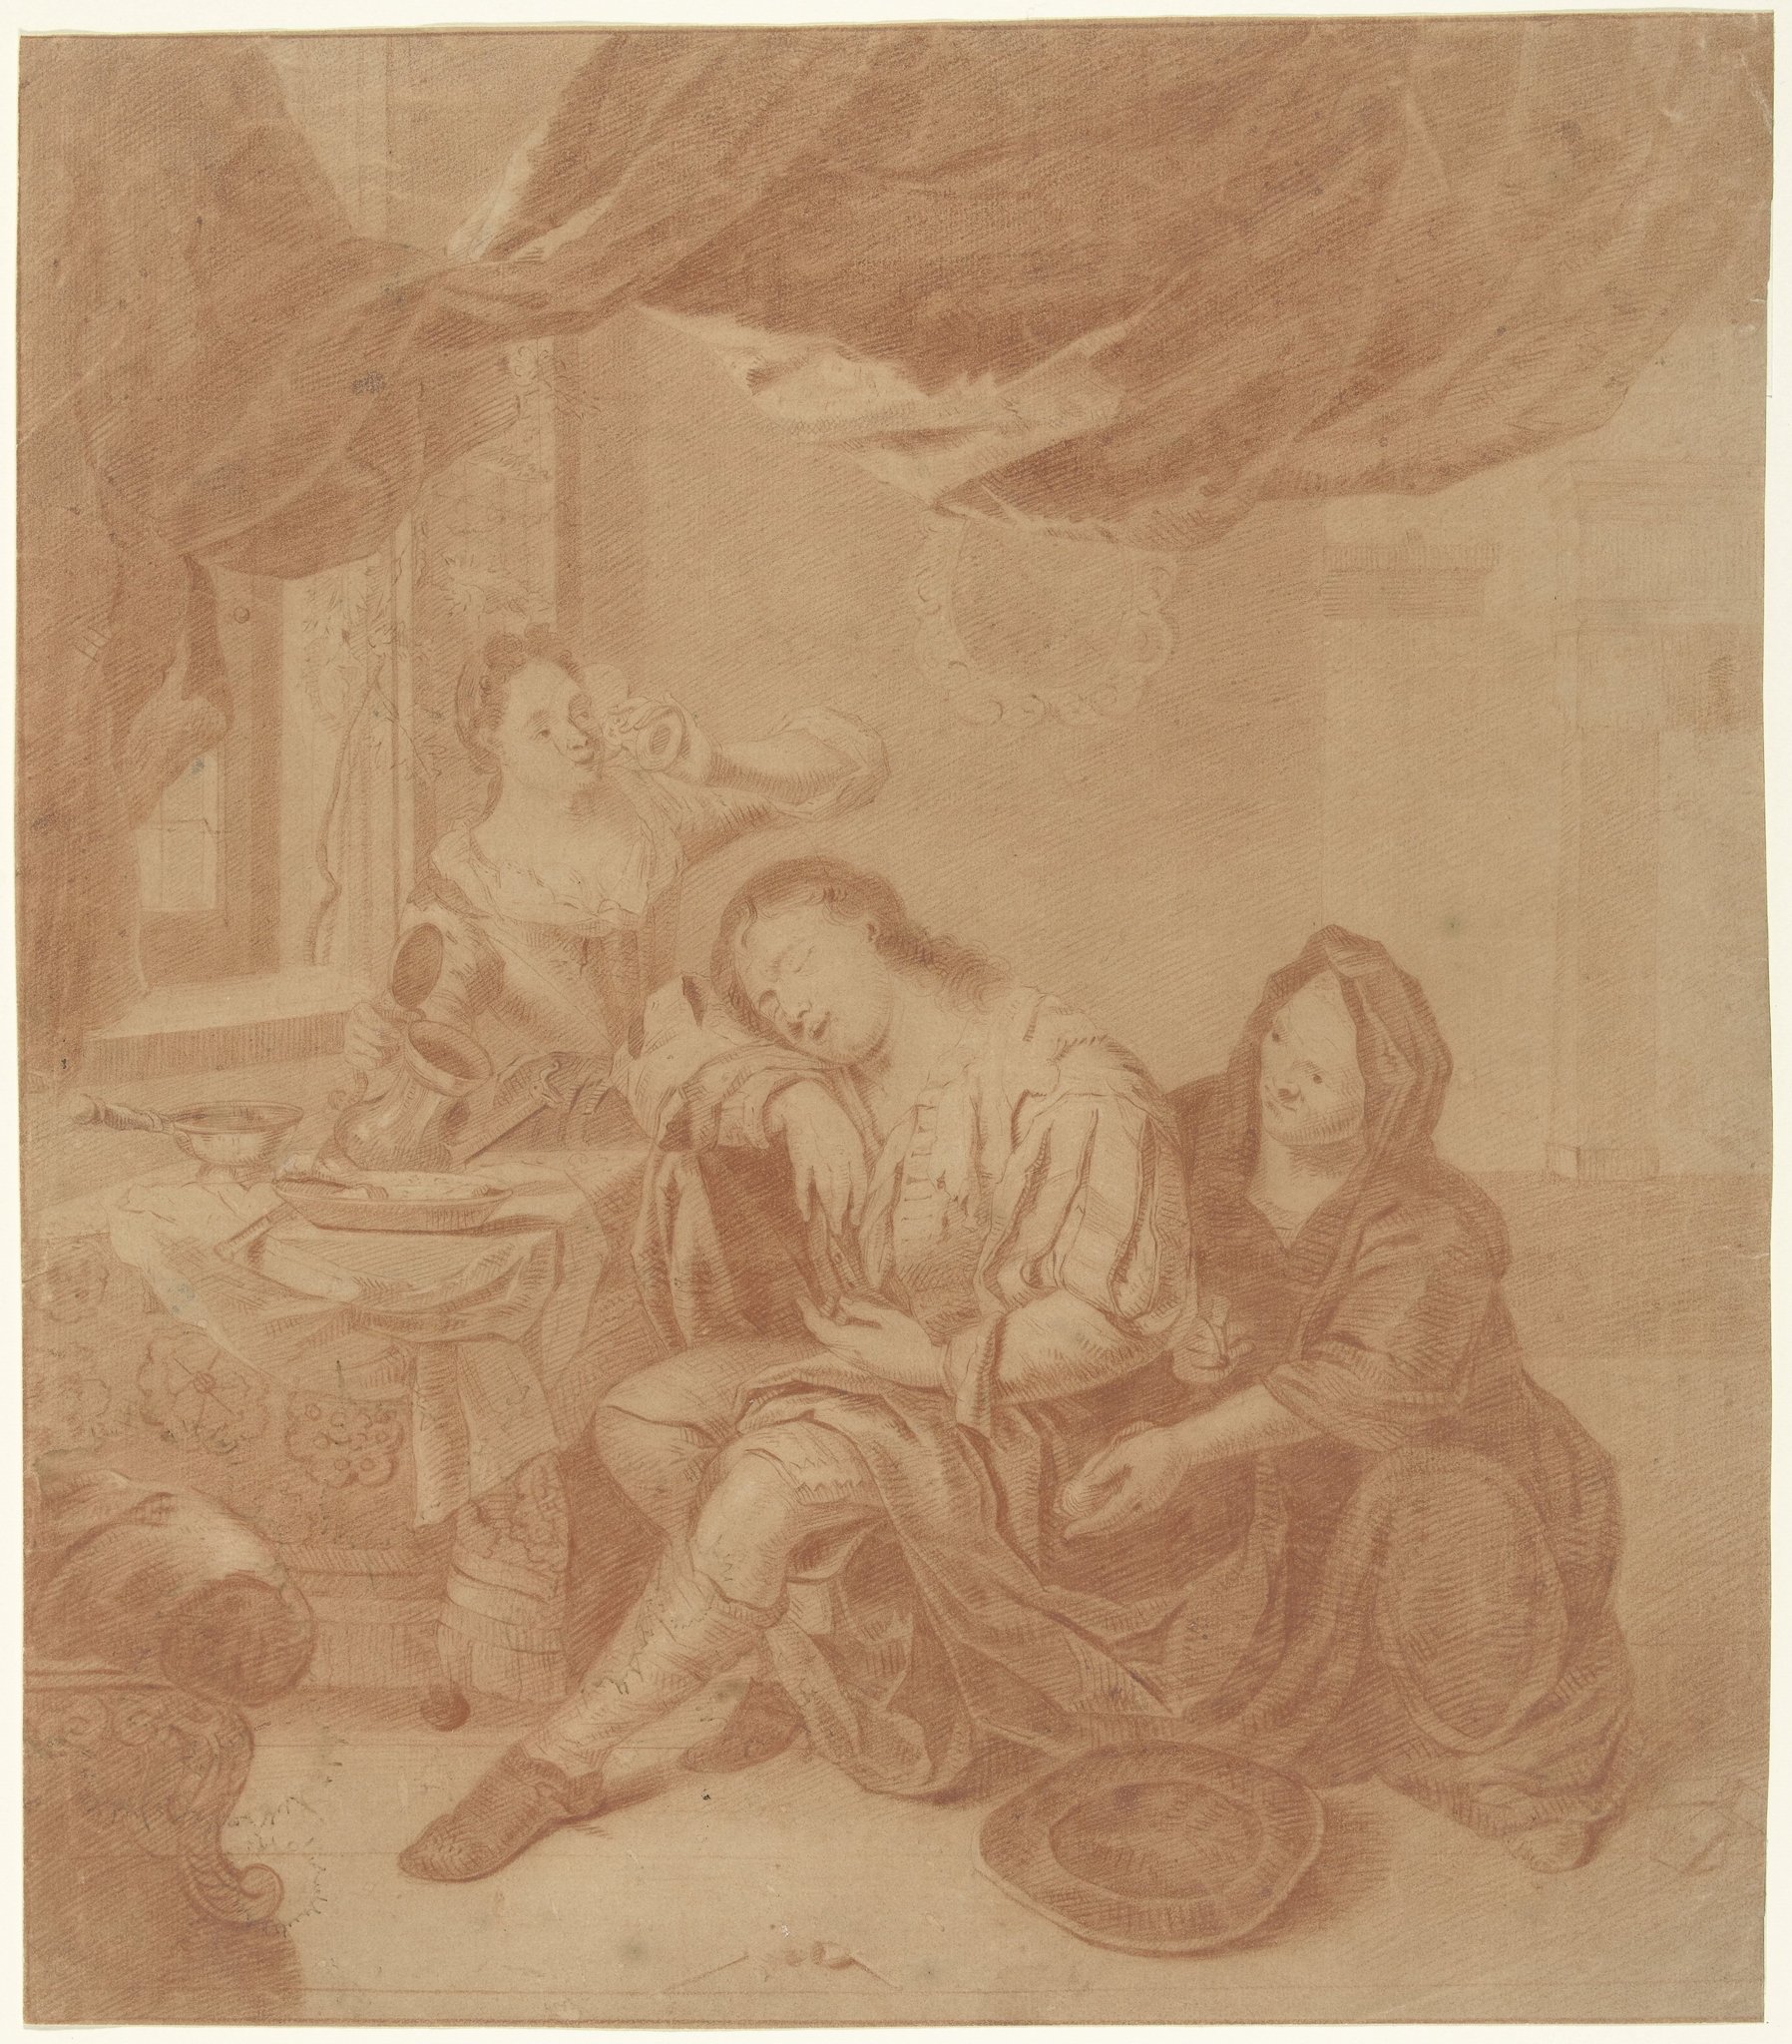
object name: drawing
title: Bordeelscène waarbij de man wordt beroofd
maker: Anonymous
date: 1700-1800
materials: chalk, paper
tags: the man is robbed (brothel scene)